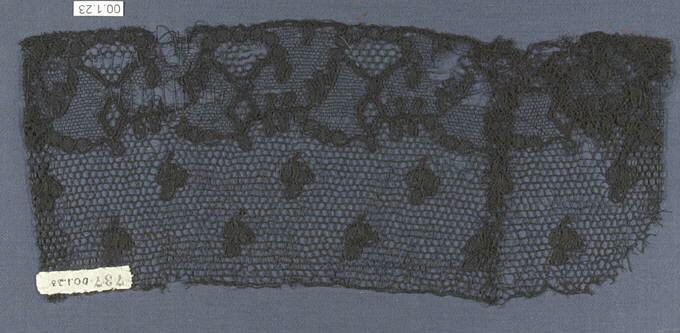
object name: fragment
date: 1801-1900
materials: silk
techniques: lace